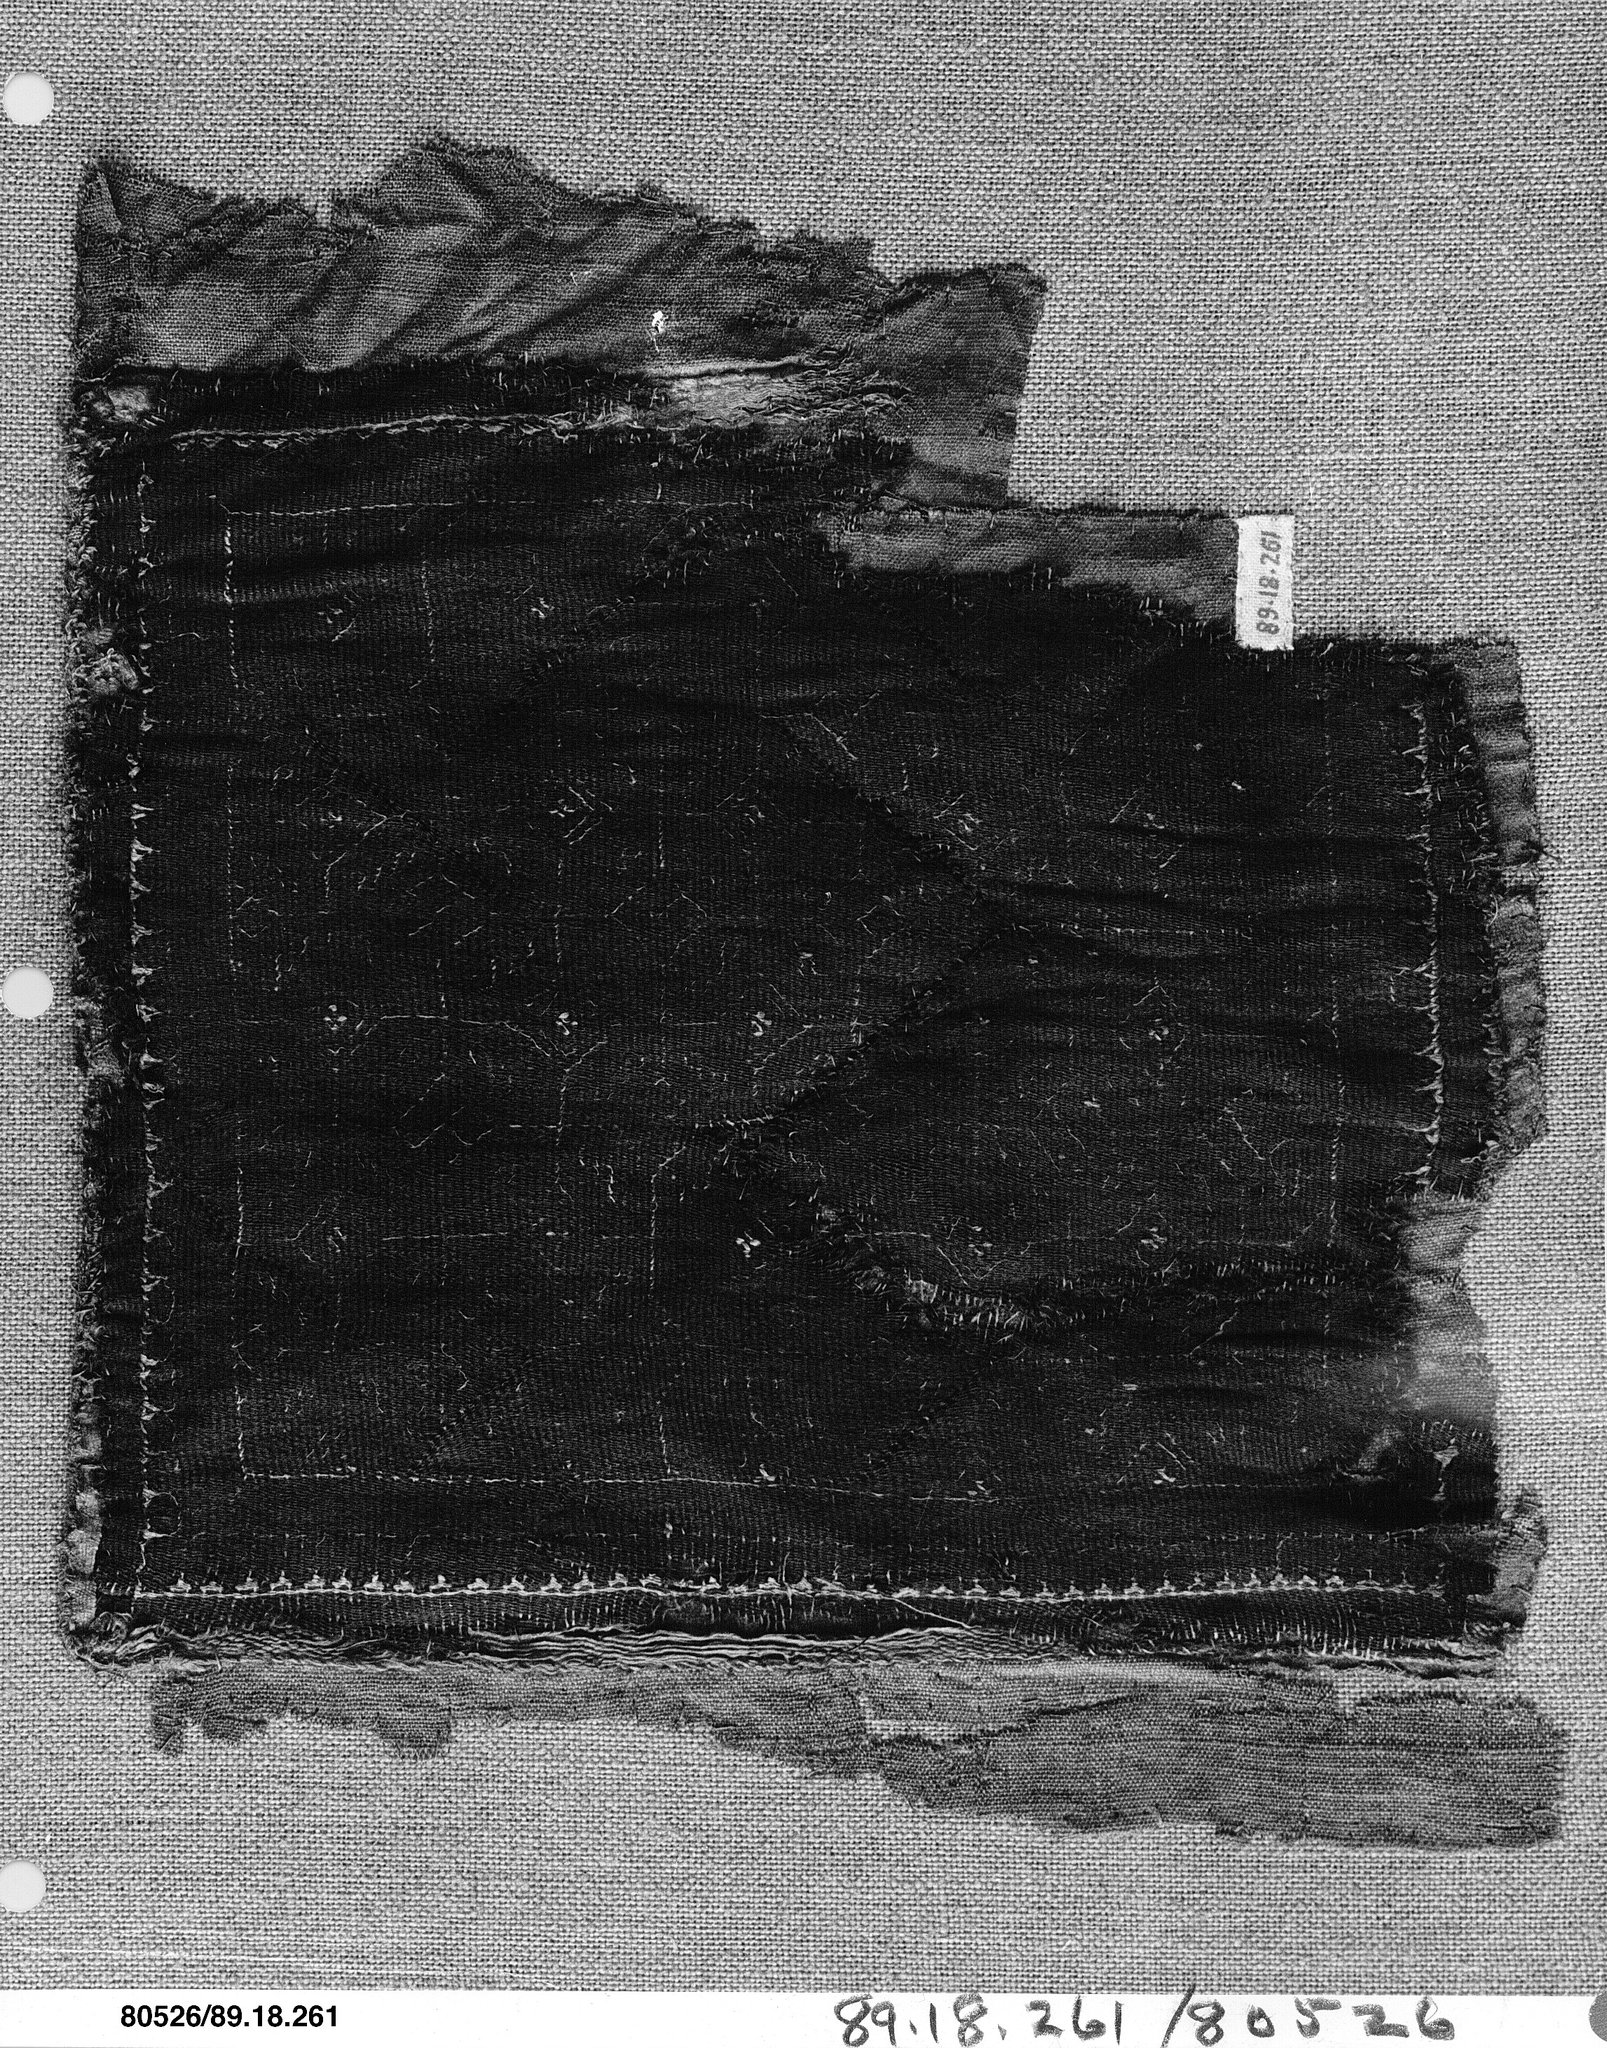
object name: textile fragment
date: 201-400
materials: linen, wool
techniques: weave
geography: egypt